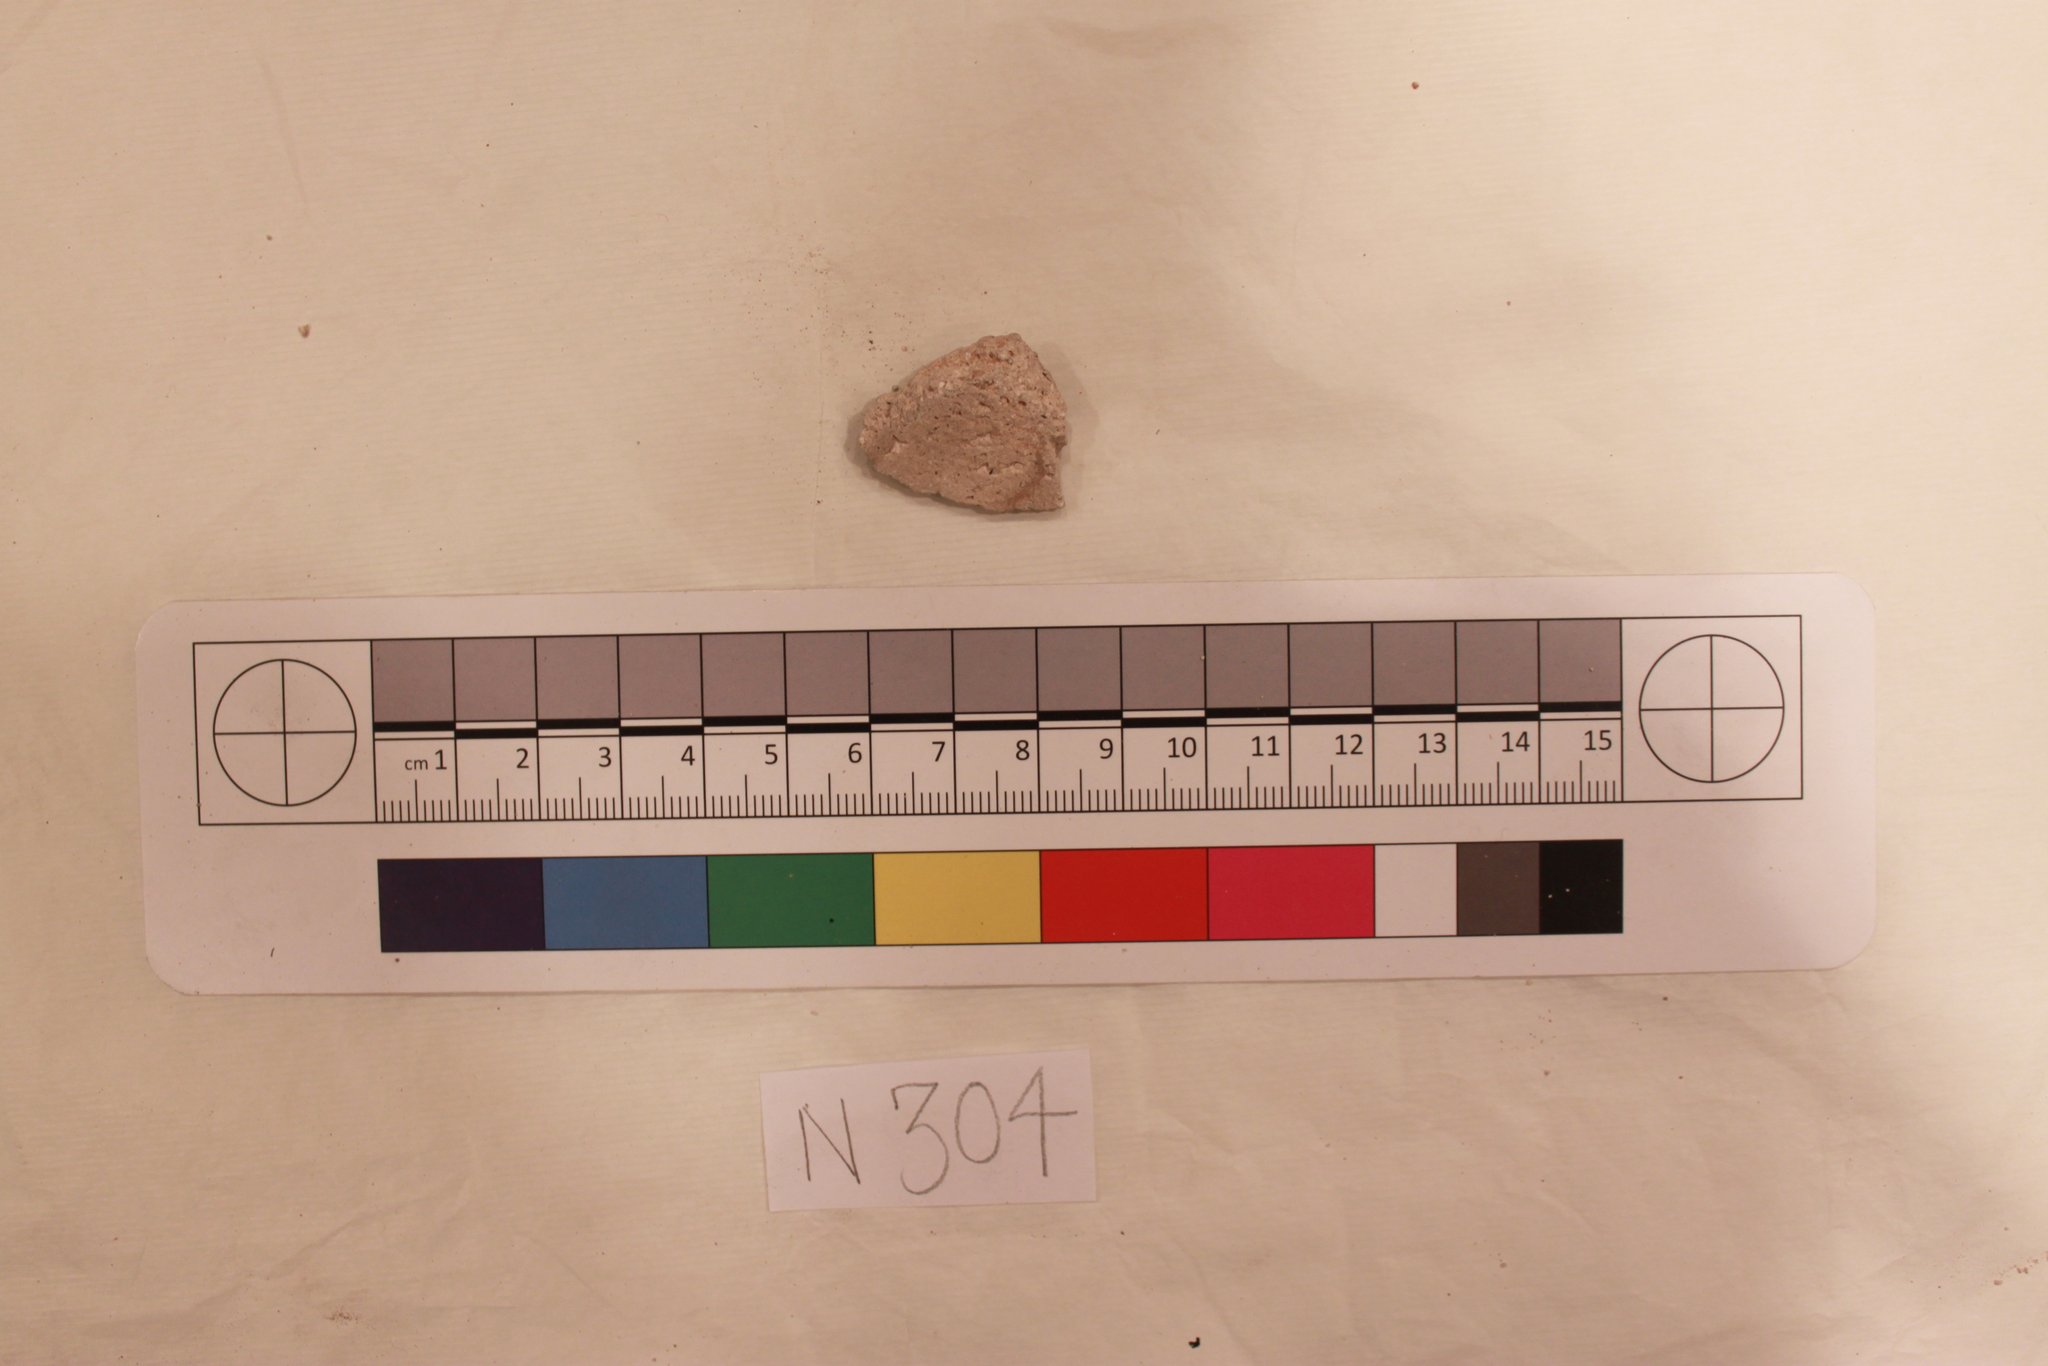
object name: fragment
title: Stucco Fragment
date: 701-1200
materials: plaster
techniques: carving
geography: iran